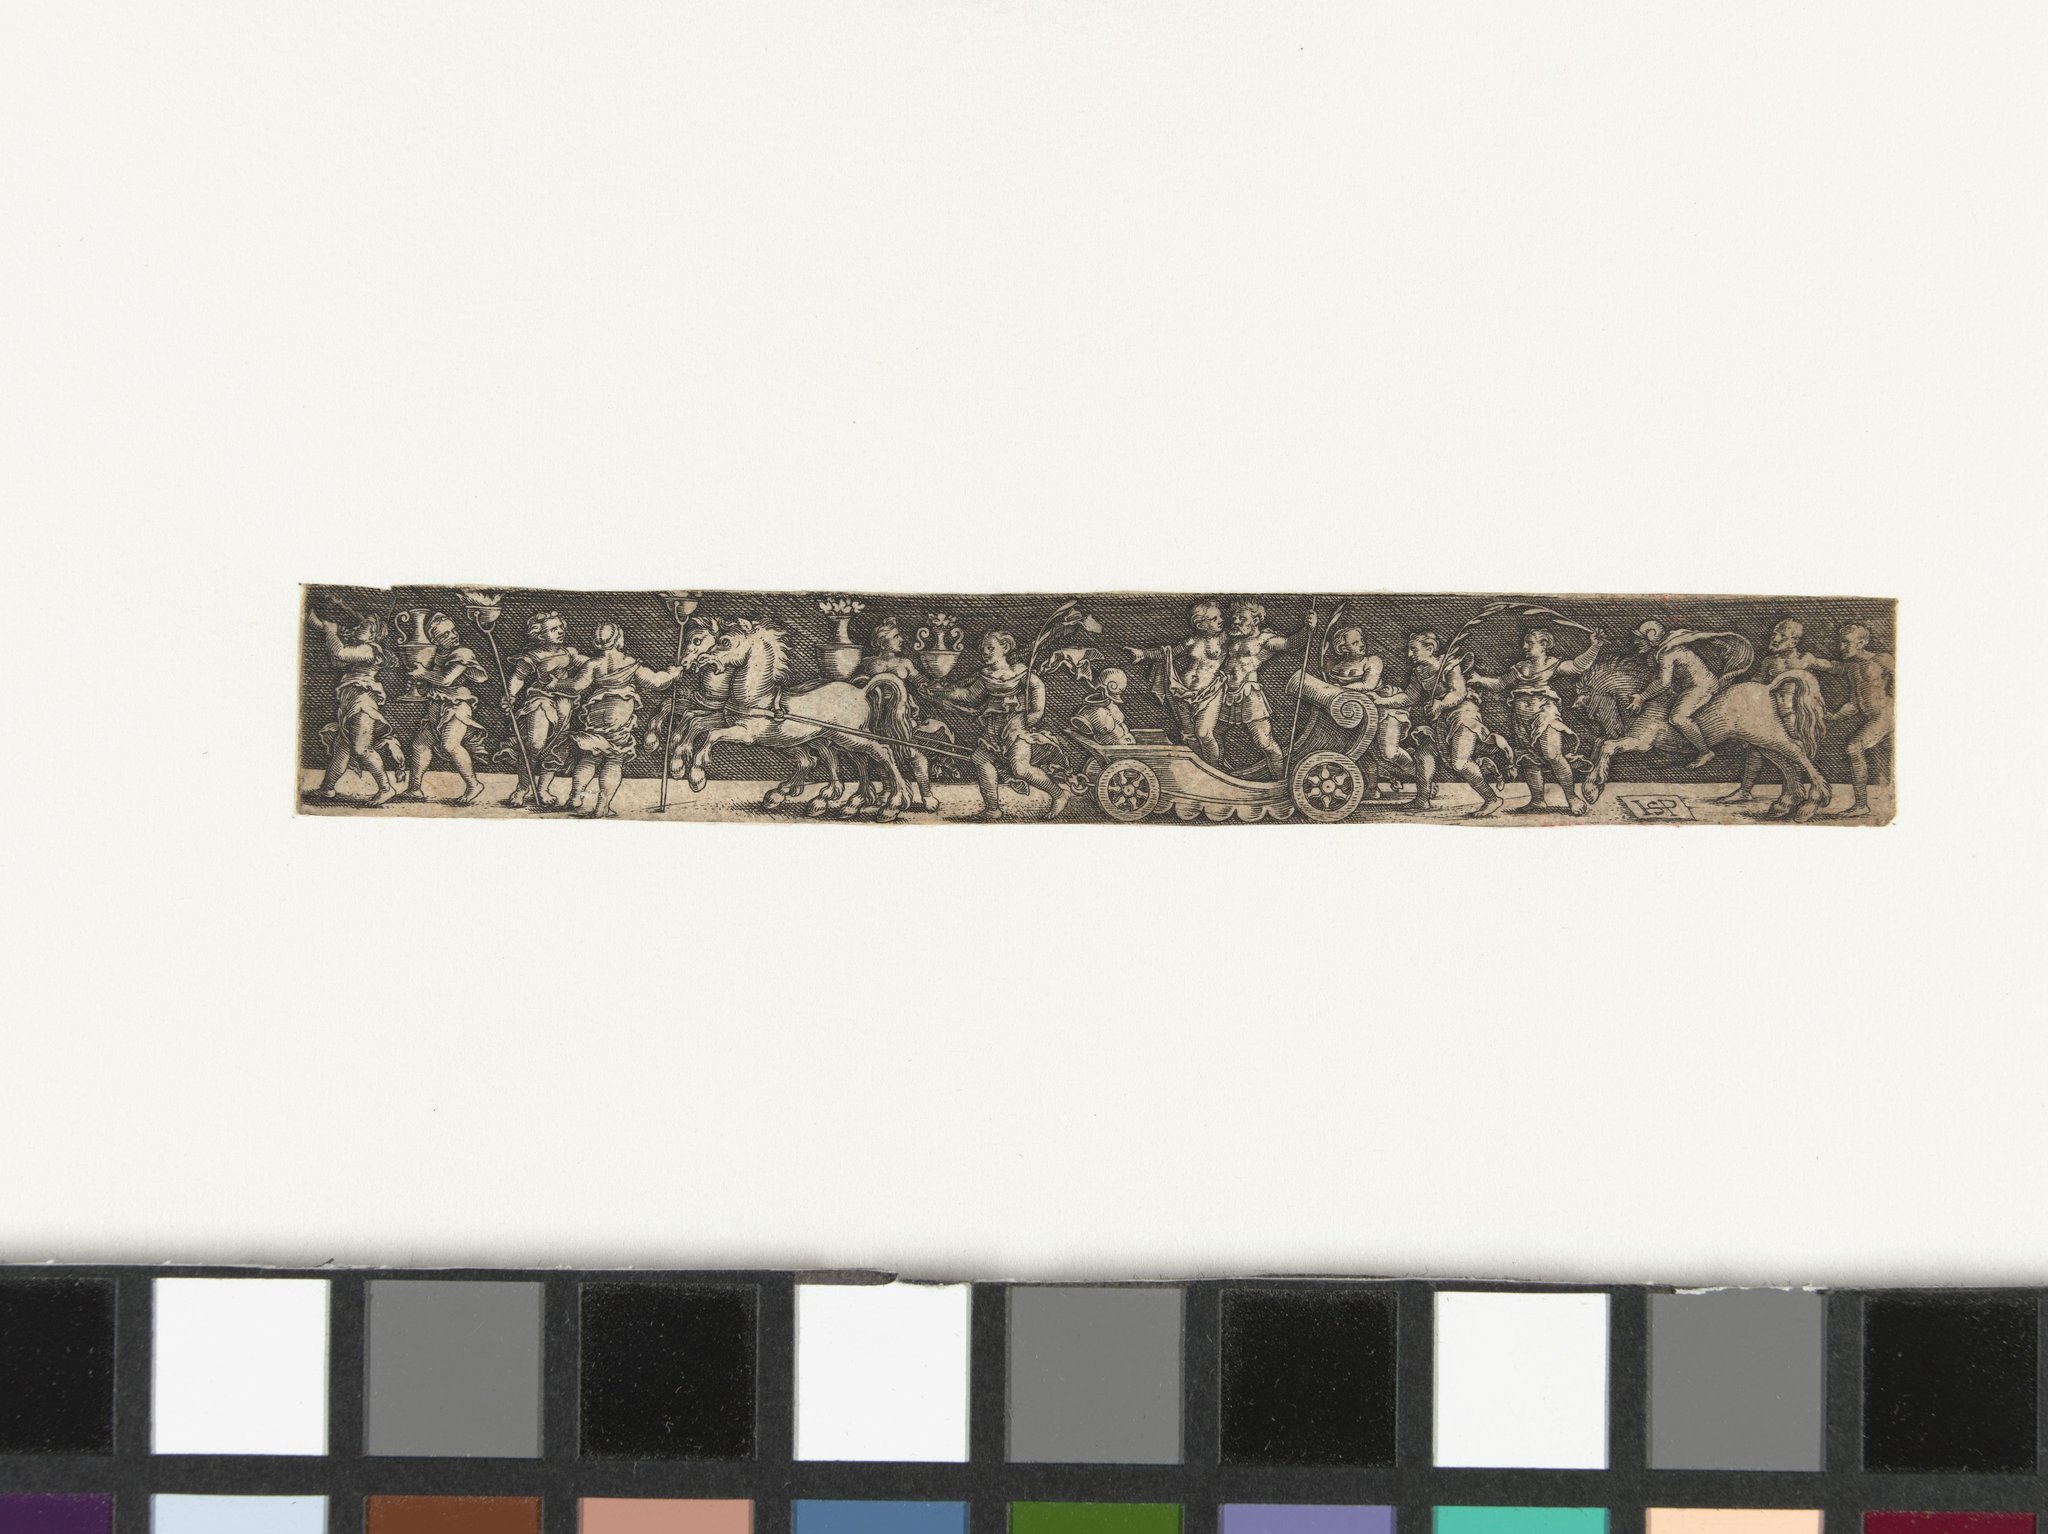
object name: print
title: Fries met een man en een vrouw in een triomfwagen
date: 1510-1550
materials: paper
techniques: engraving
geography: germany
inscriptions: collector's mark: Lugt 240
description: De triomfwagen wordt getrokken door twee paarden. Achter de wagen lopen vrouwen en rijdt een ruiter. Vooruit lopen vrouwen met fakkels, kannen en een hoorn. Gearceerde achtergrond.